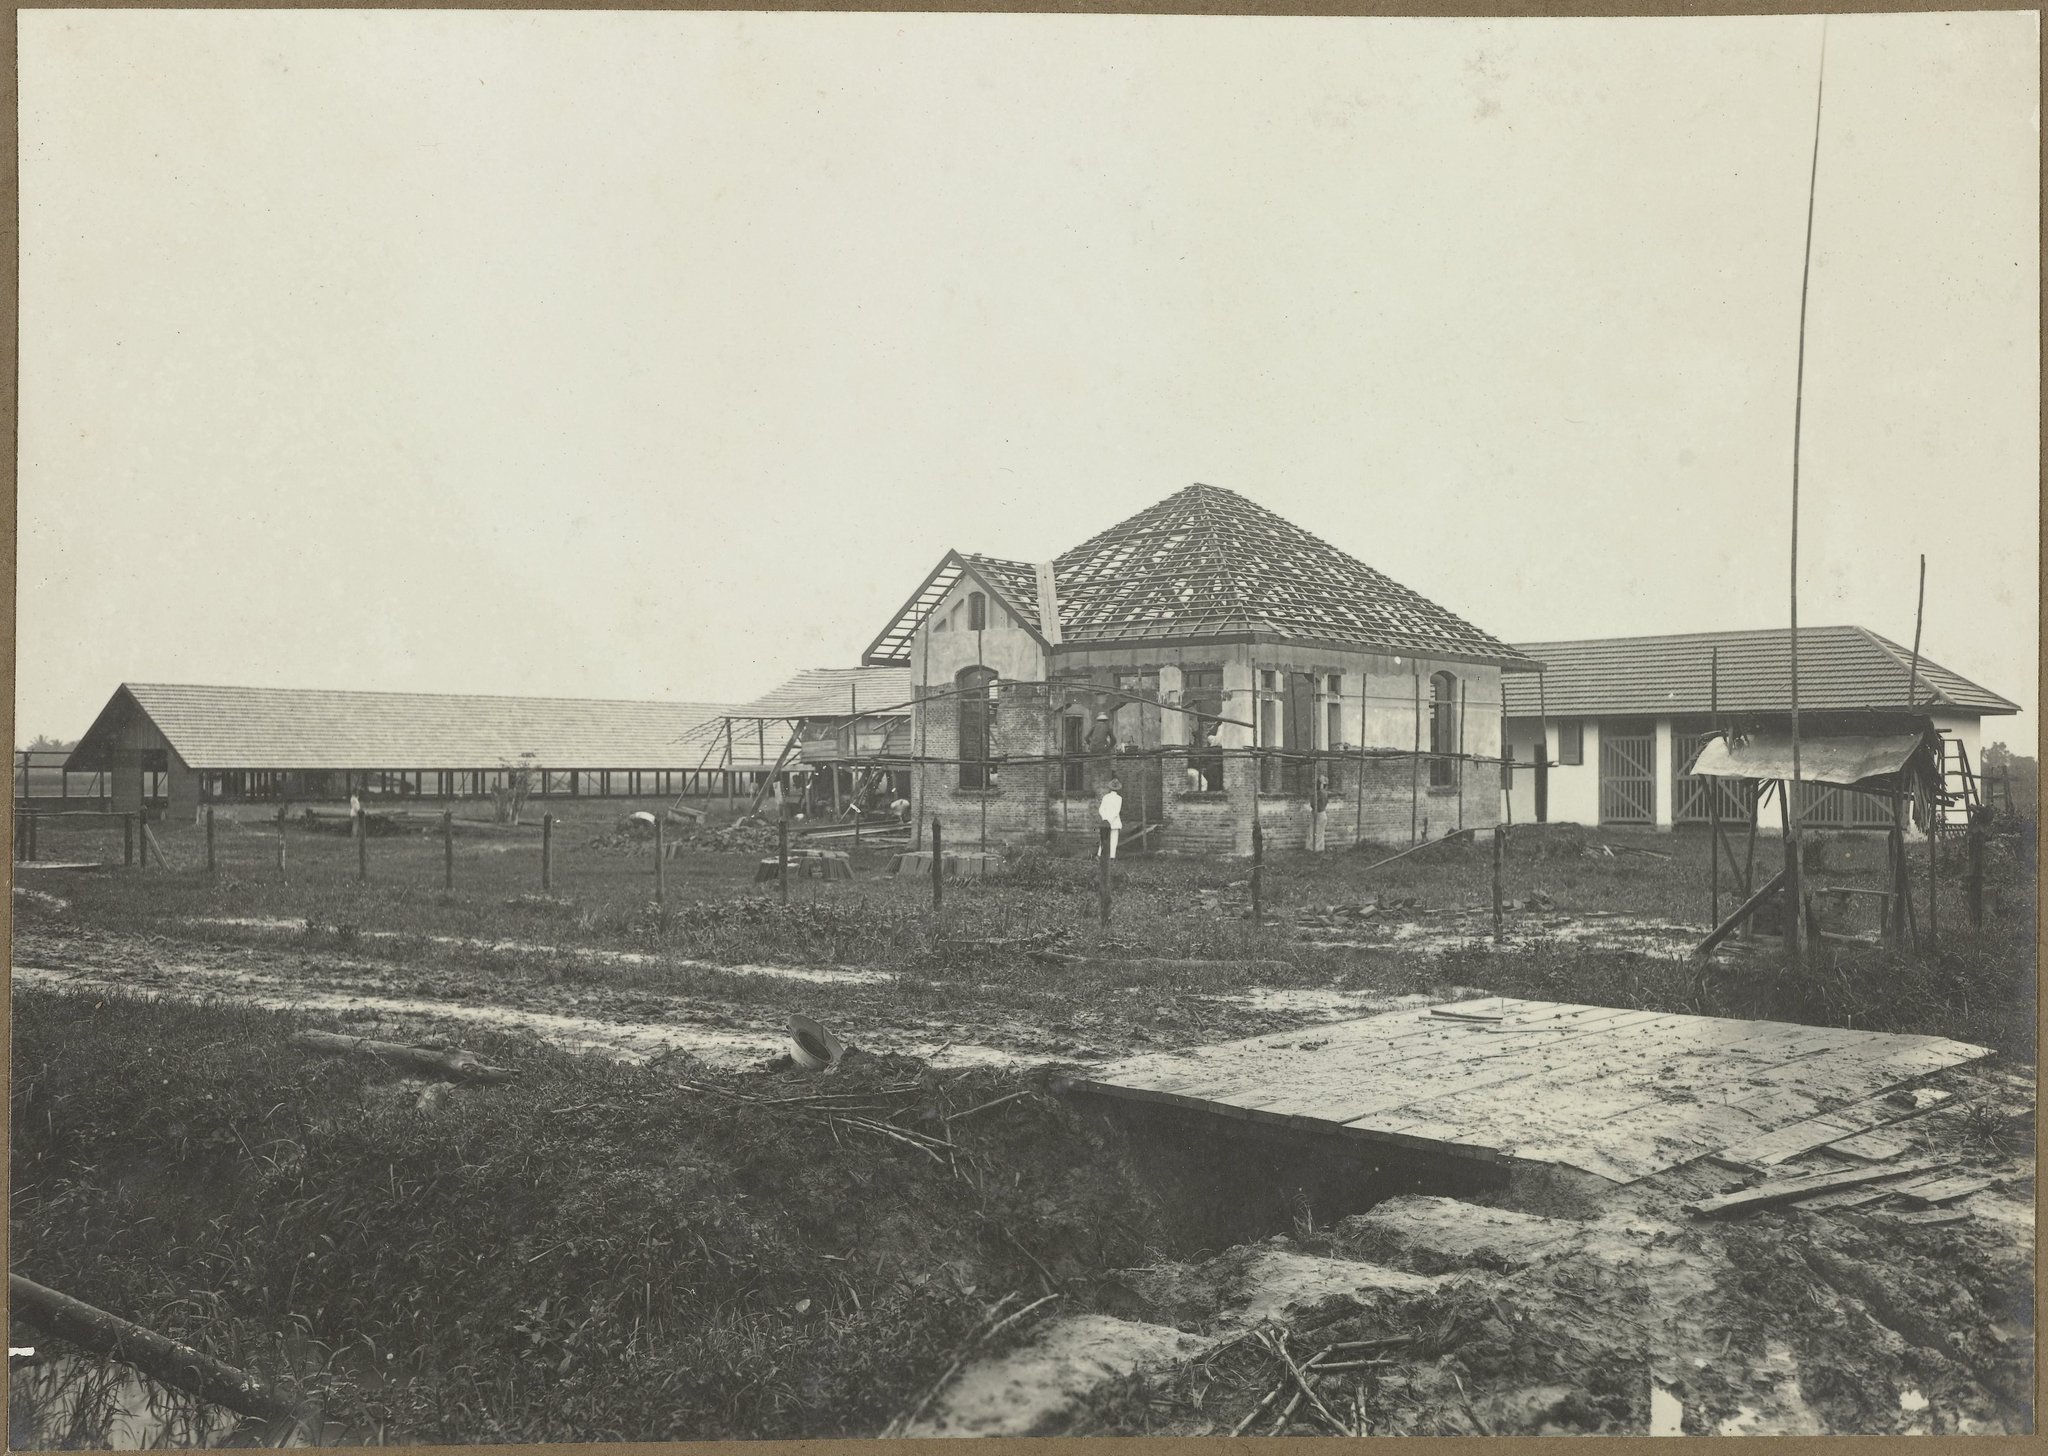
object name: photograph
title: Villa in aanbouw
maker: Anonymous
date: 1914-1919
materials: photographic support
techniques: gelatin silver print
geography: medan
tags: making the overground structures (~ building activities), detached house in city, representation of real building (either existing or having existed), architecture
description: Een villa in aanbouw, waarschijnlijk te Medan. Op de voorgrond een brug over een greppel naar het bouwterrein. Foto in het fotoalbum van het Nederlandse architectenbureau en aannemersbedrijf Bennink en Riphagen te Medan in de jaren ca. 1914-1919.